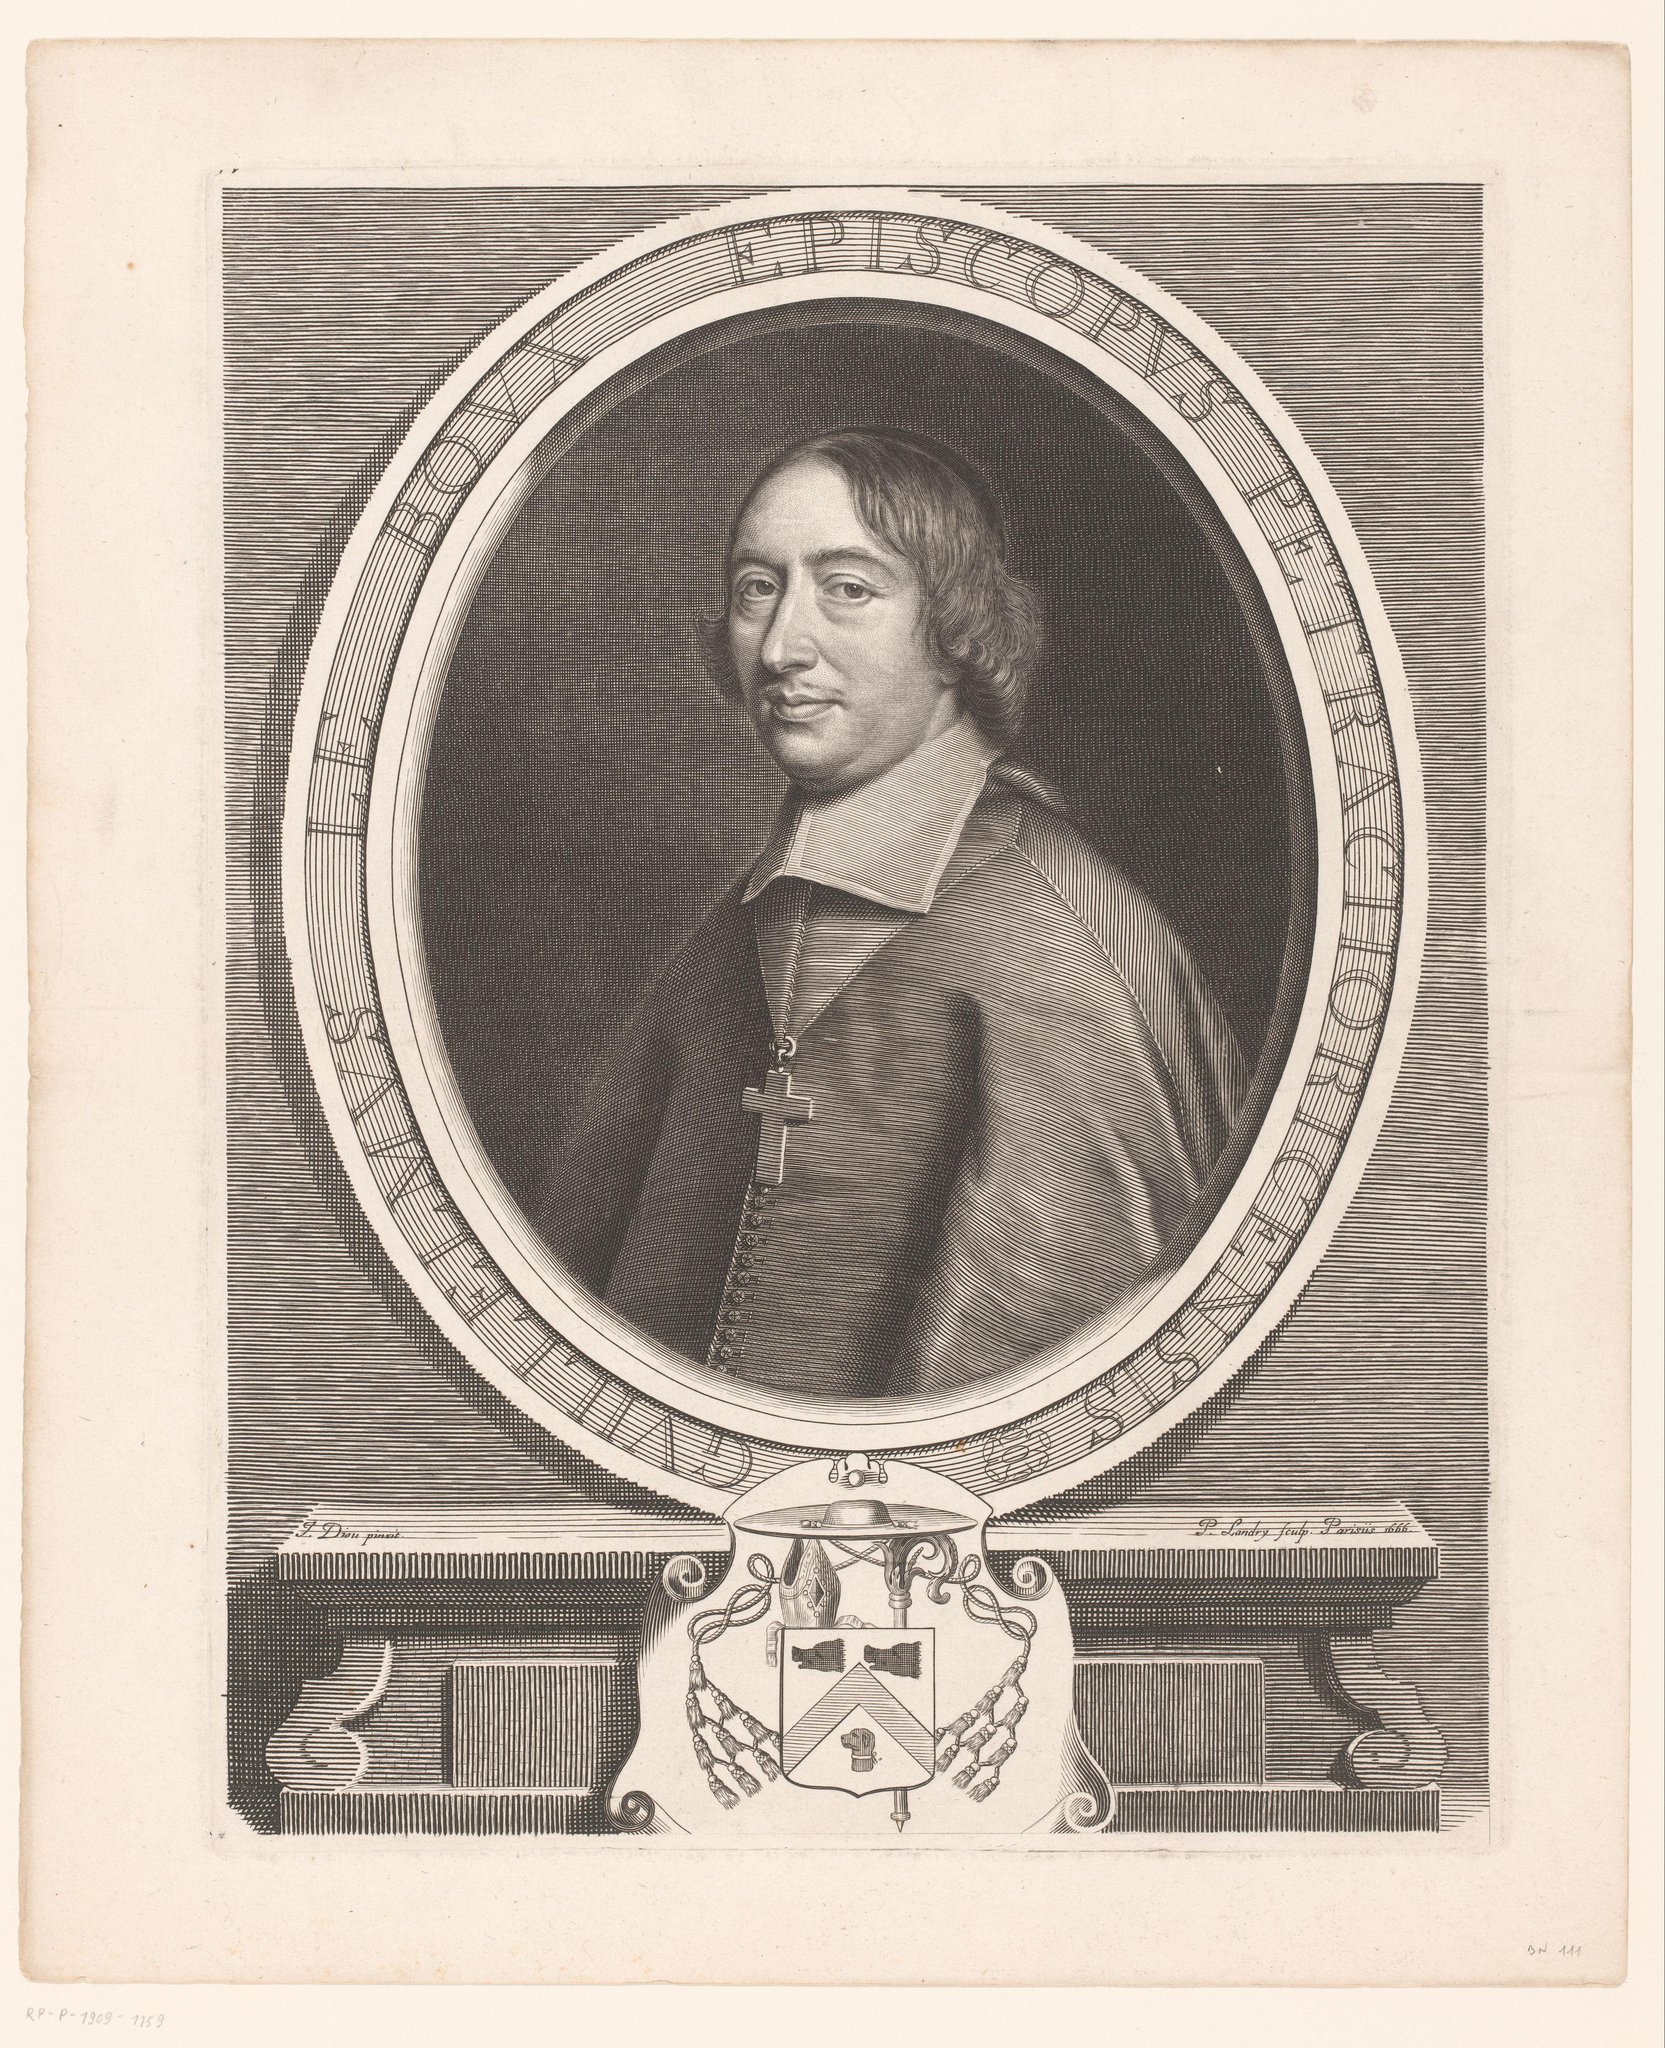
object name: print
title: Portret van Guillaume Le Boux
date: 1666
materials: paper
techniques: engraving, etching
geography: paris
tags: archbishop, bishop, etc. (roman catholic), historical persons, armorial bearing, heraldry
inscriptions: collector's mark: Lugt 2228